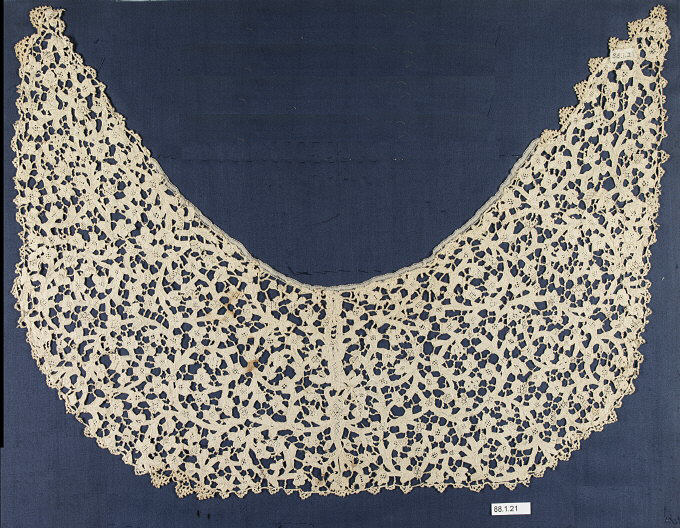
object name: cape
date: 1701-1800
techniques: lace